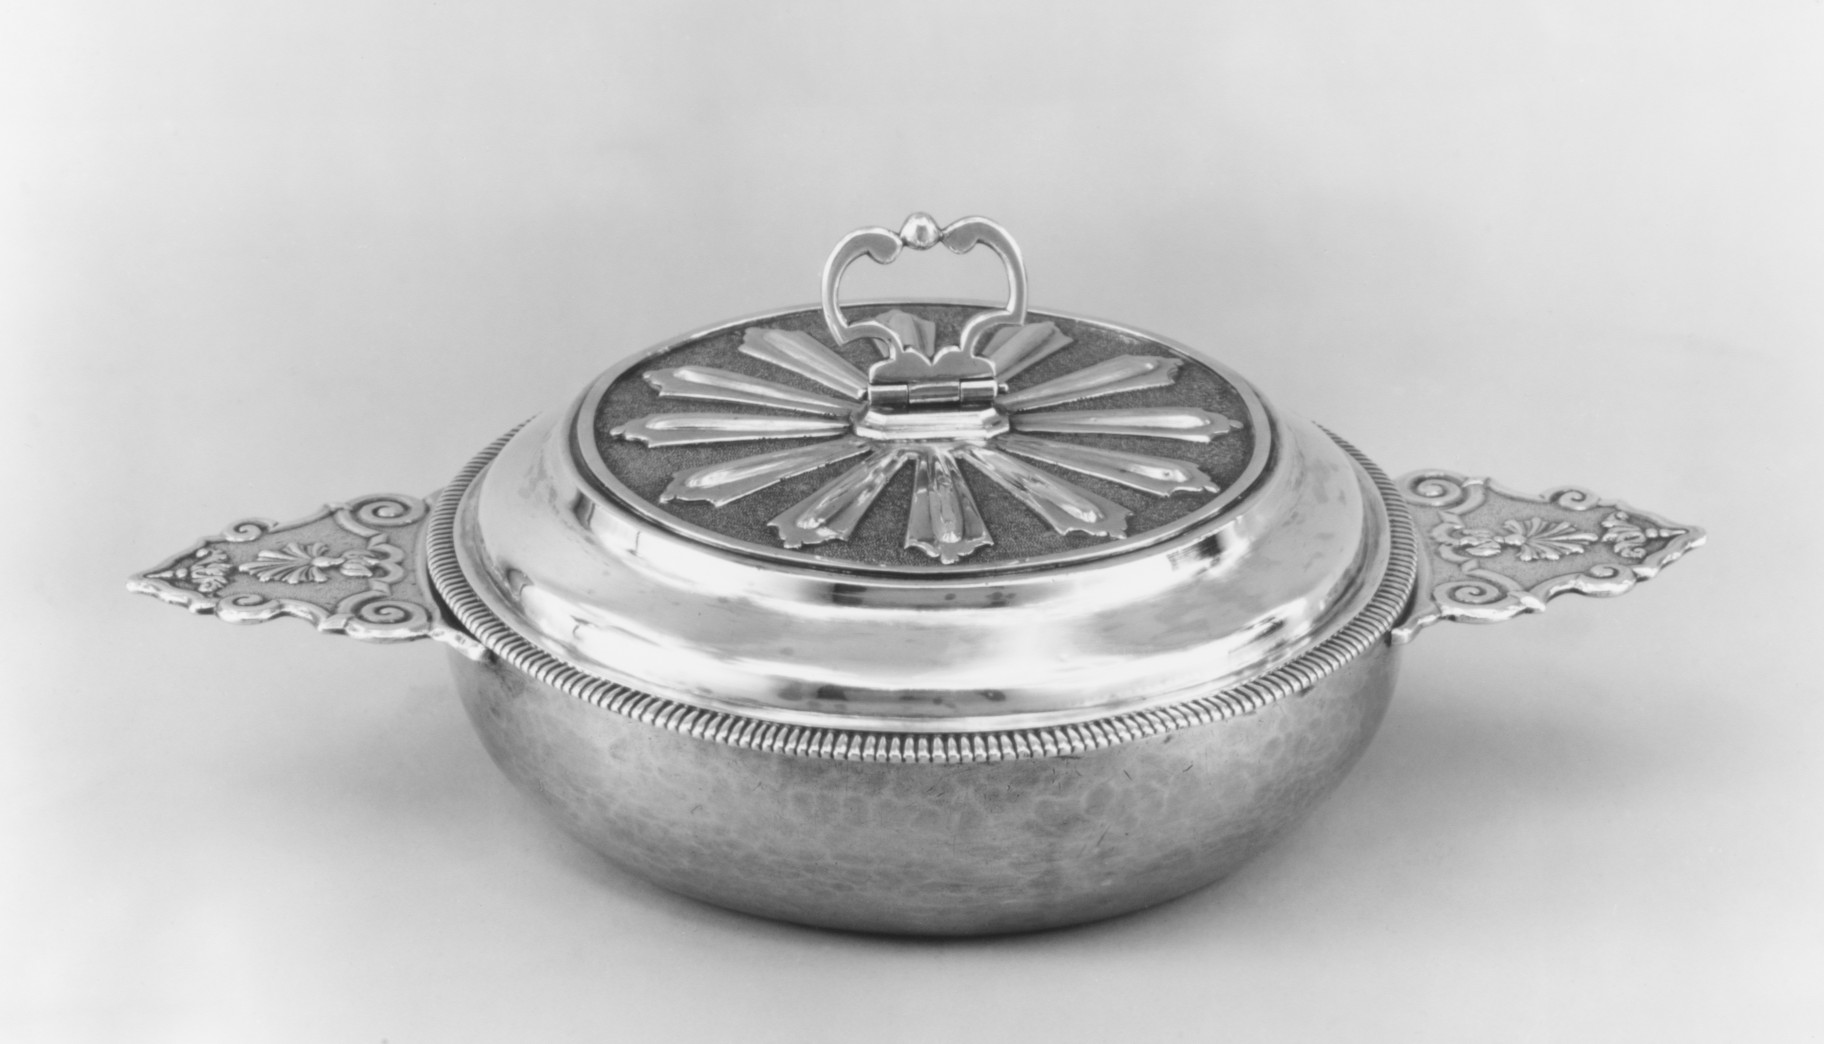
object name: bowl with cover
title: Bowl with cover (Écuelle)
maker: nicolas ii fauveau the elder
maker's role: maker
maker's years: 1672-1724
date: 1701-1725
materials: silver